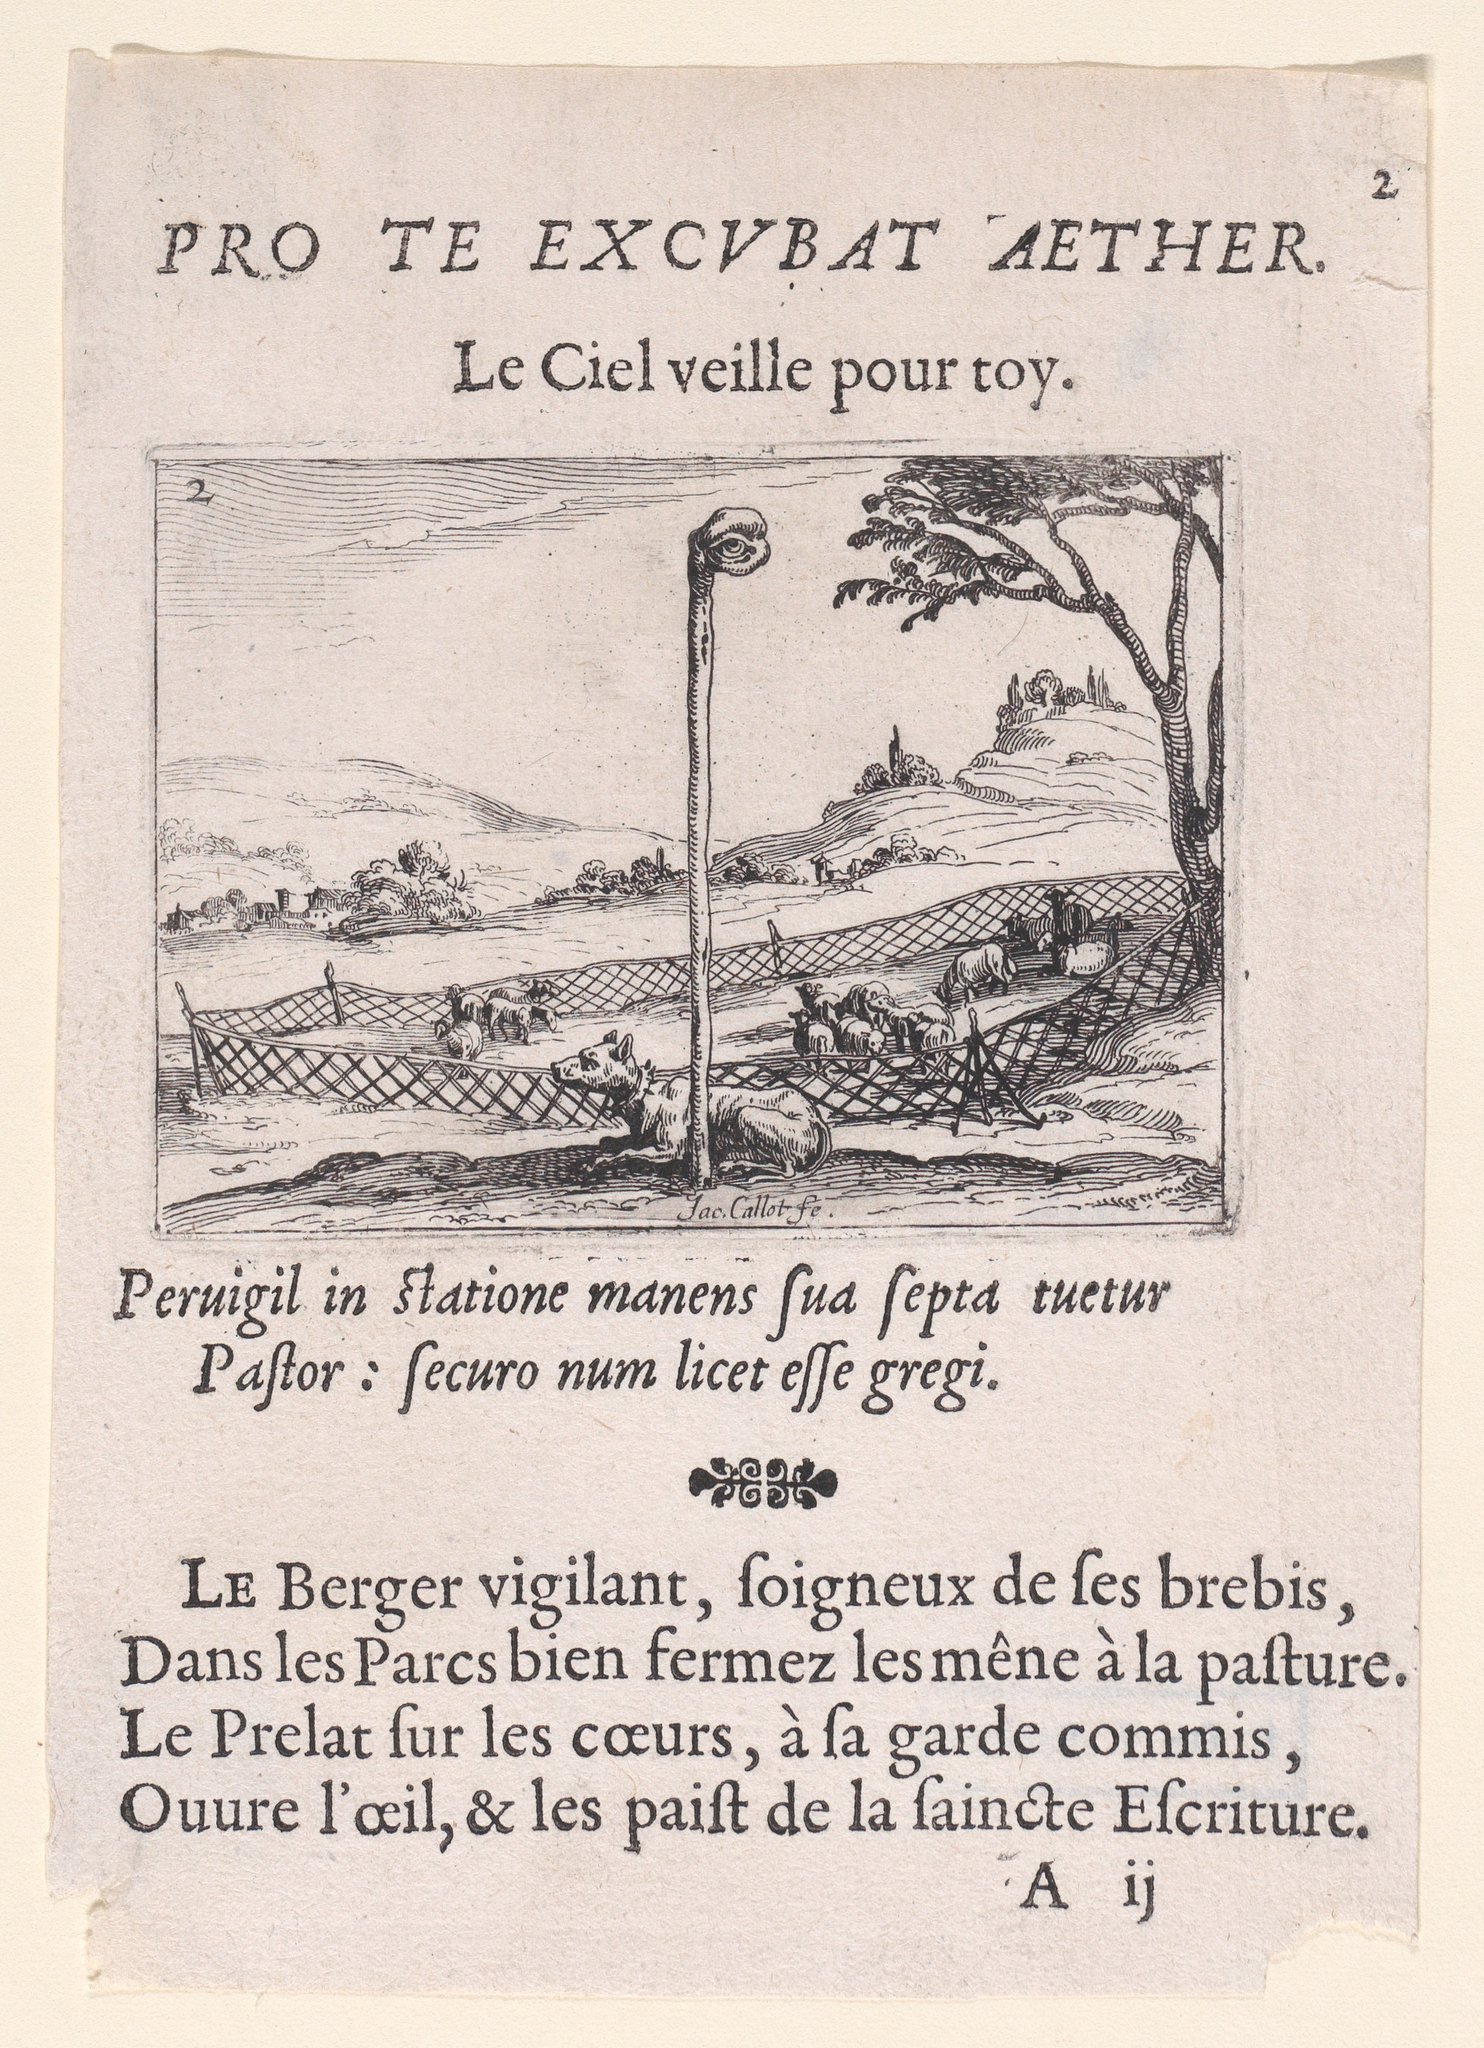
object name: print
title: L'Oeil Vigilant (The Vigilant Eye), plate 2 from "Lux Claustri ou La Lumière du Cloitre" (The Light of the Cloisters)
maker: jacques callot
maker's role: artist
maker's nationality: french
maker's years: 1592-1635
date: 1621-1635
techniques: etching, letterpress